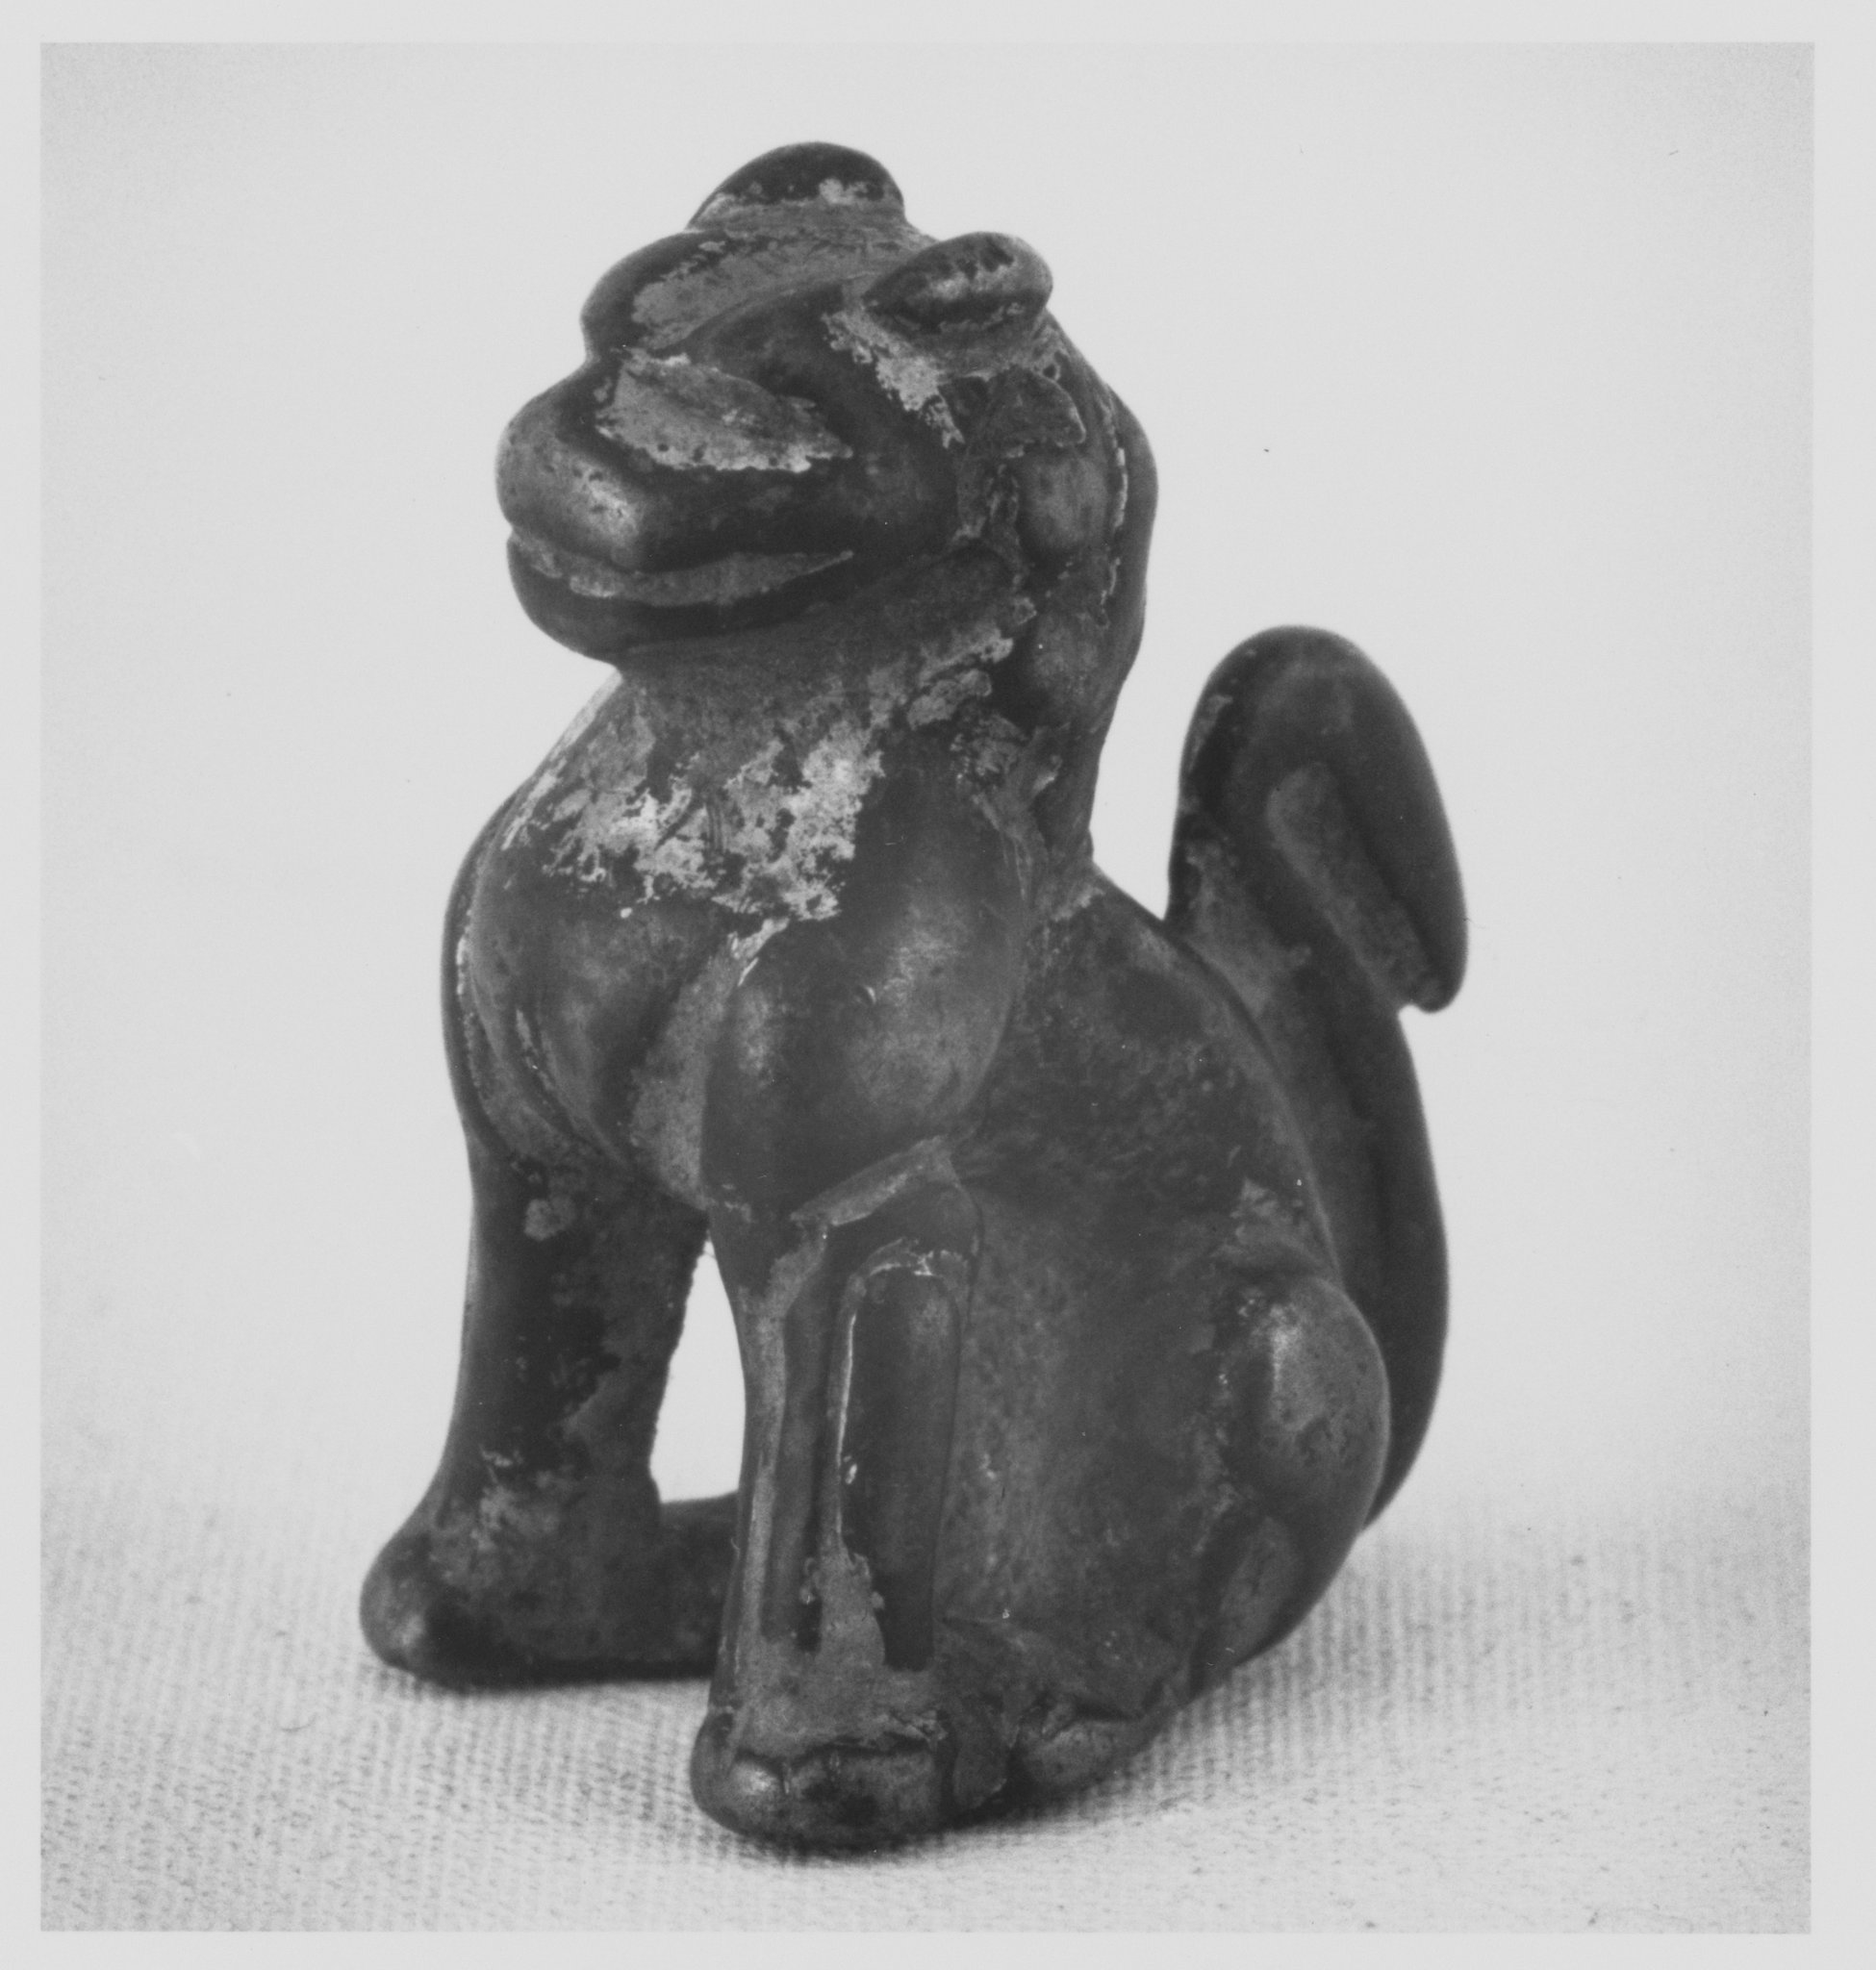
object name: figure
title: Lion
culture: chinese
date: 618-907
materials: gilt bronze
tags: lions